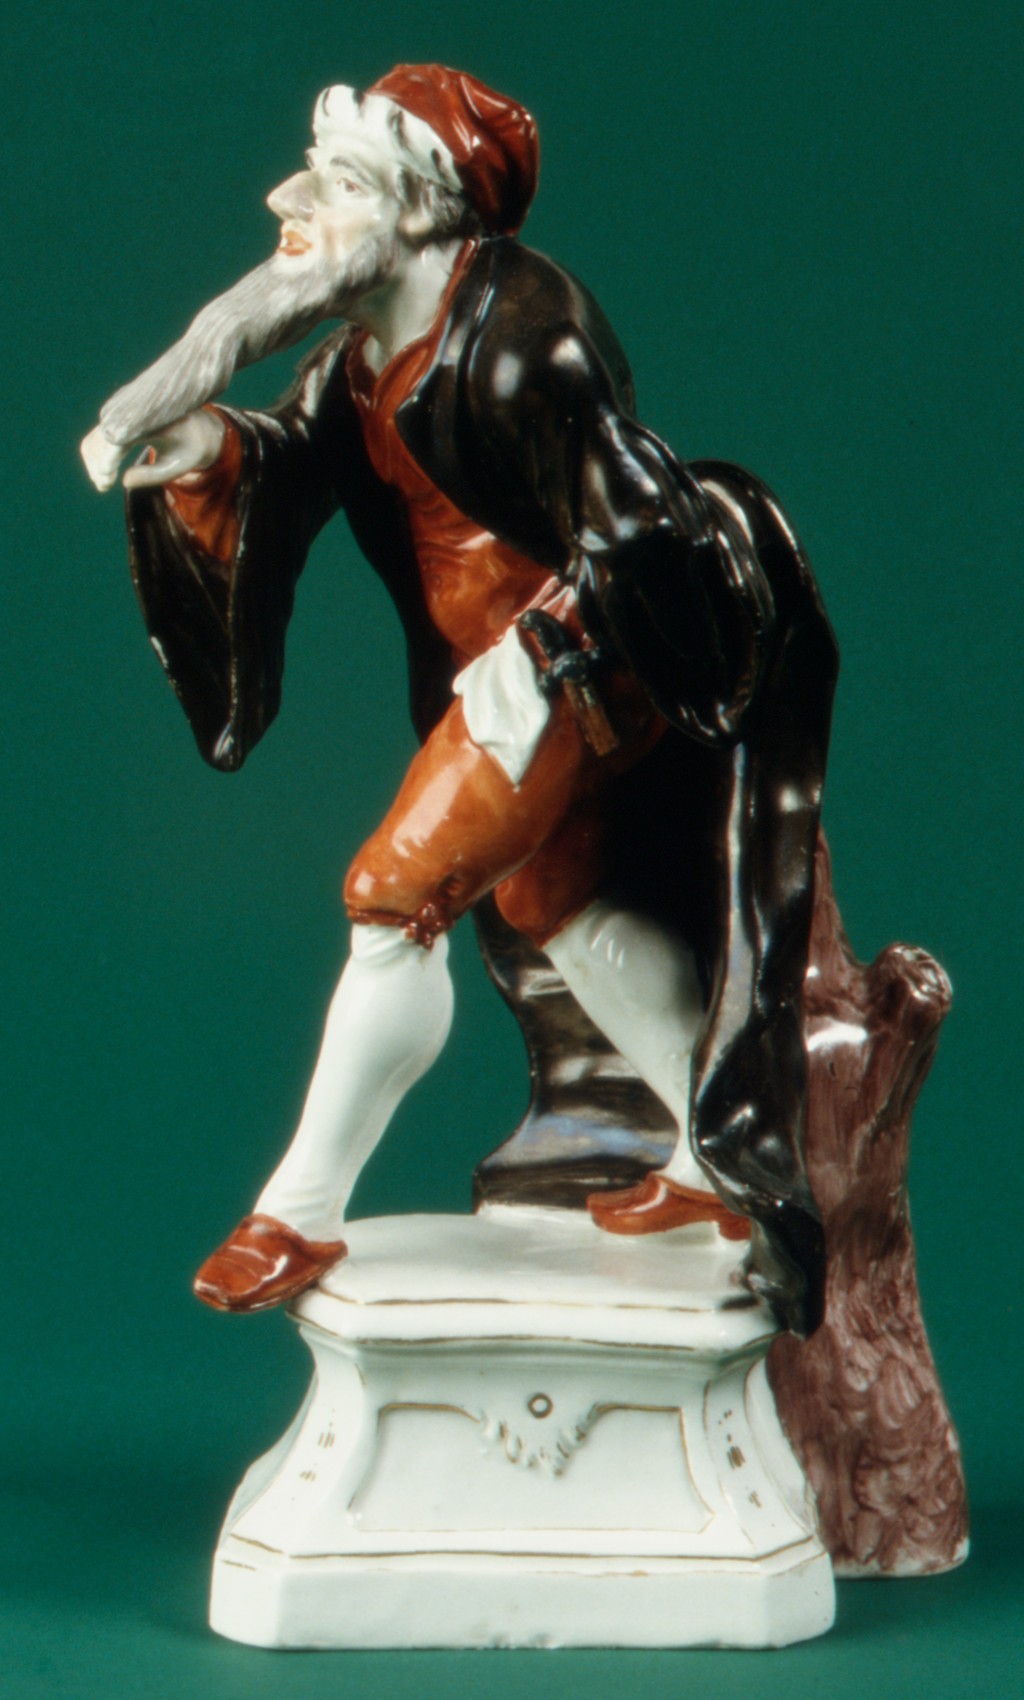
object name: figure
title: Pantaloon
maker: höchst manufactory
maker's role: manufactory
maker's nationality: german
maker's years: 1746-1796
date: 1750-1753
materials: hard paste porcelain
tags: men